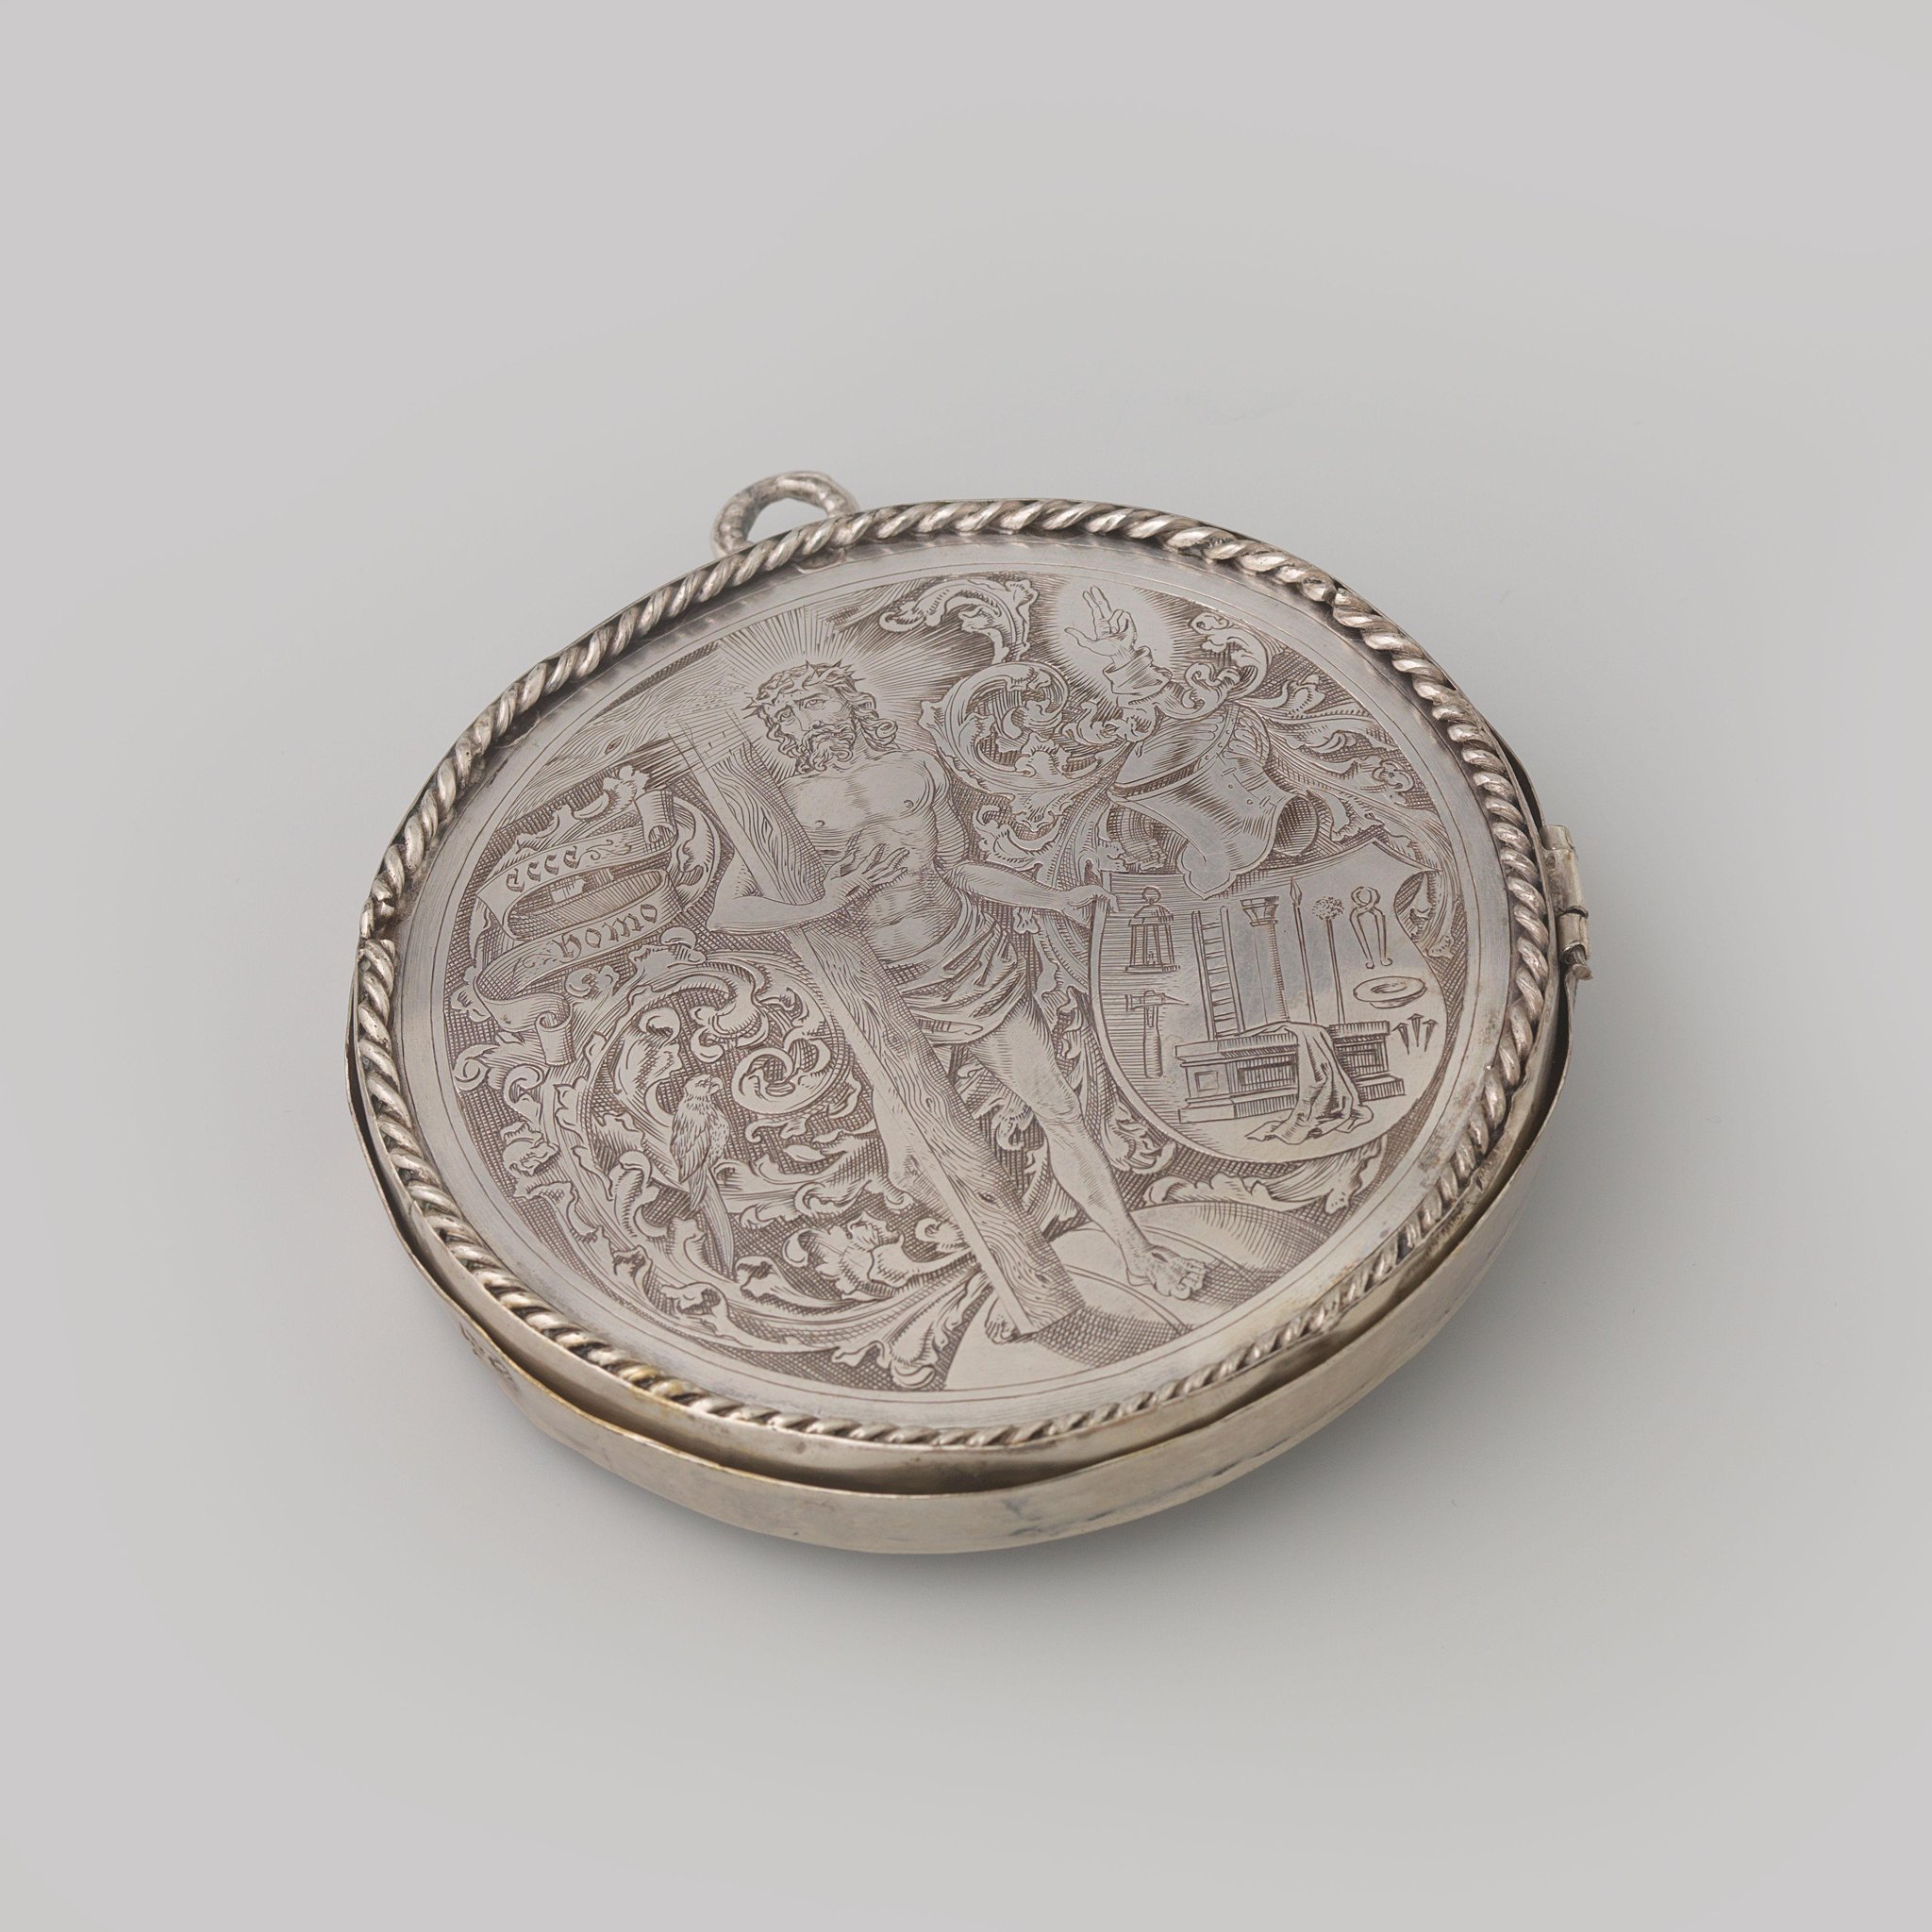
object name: host box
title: Pyxis of hostiedoos van zilver, in de vorm van een schijf,versierd met Madonna met Kind en met Christus op wereldbol.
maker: Anonymous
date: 1500-1515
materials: silver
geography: bremen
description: Pyxis van zilver, in de vorm van een schijf. Binnen een stralenkrans een maansikkel waarin de Madonna met Kind. Op de achterzijde gegraveerd: Christus op de wereldbol, het Kruis in de rechterarm in de linker een schild met de passiewerktuigen. Links een banderolle met Ecce Homo. Merken: gekroond monogram van A.T., een sleutel.